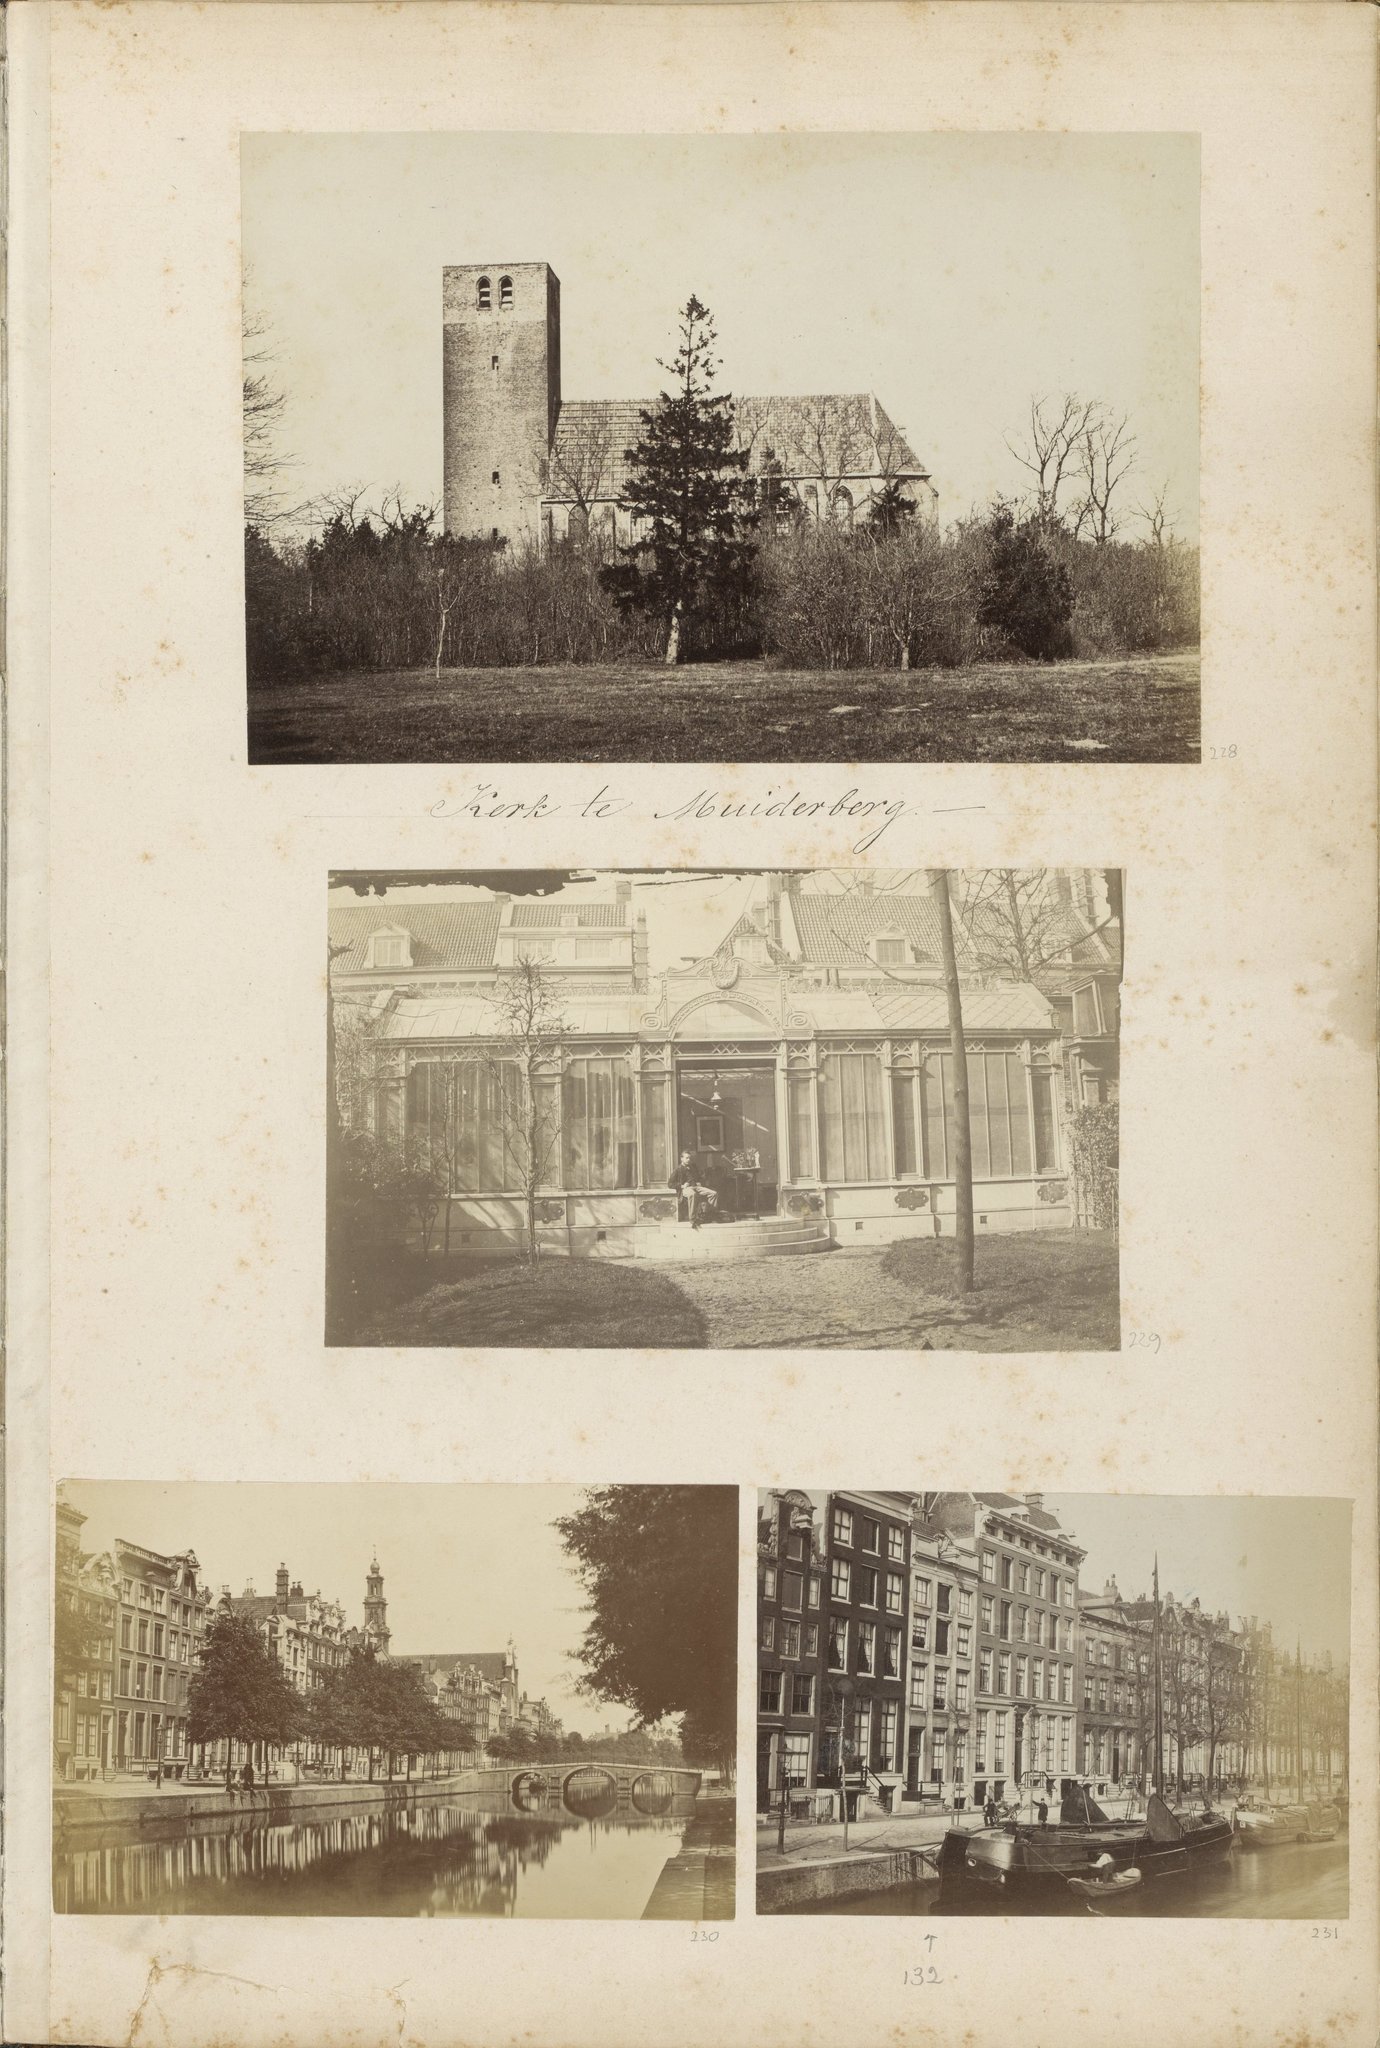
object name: album leaf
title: Gezicht op de Keizersgracht te Amsterdam met op de achtergrond de toren van de Westerkerk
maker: Anonymous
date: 1864-1880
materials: paper, photographic support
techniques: albumen print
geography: amsterdam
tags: claude august crommelin (1840-1874), canals, waters (in city), amsterdam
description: Onderdeel van het Fotoalbum van Robert Daniel Crommelin (1841-1907). De foto in het midden toont het fotoatelier van Claude August Crommelin in de tuin van Herengracht 132 te Amsterdam.